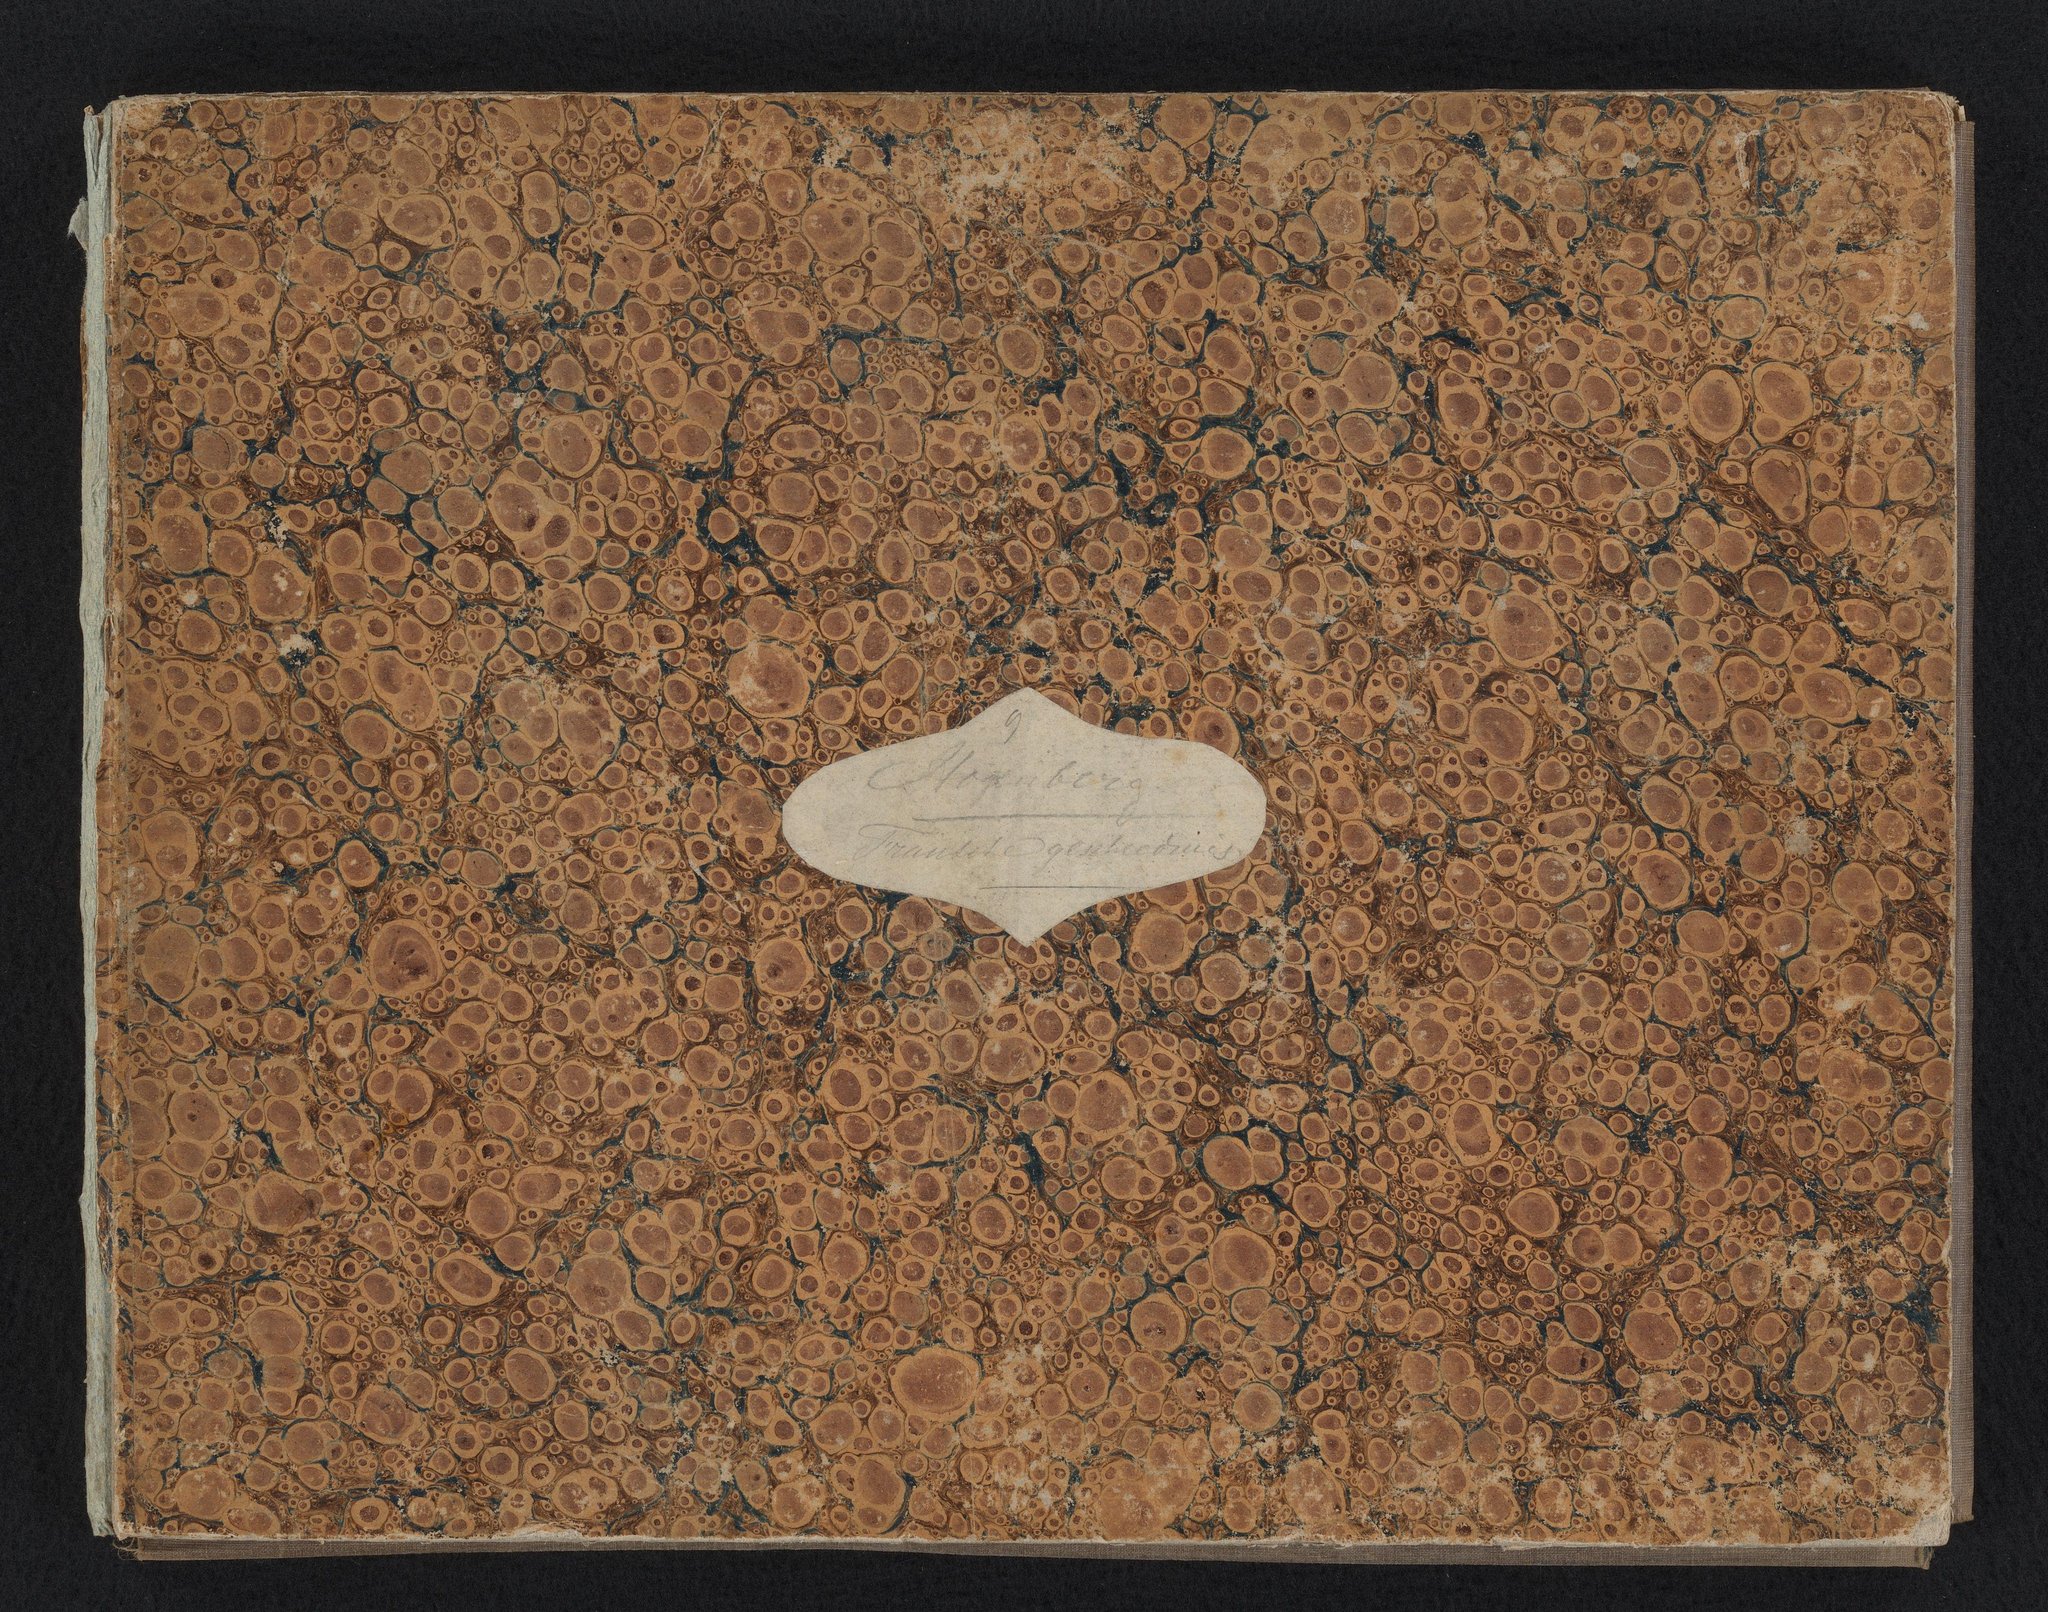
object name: prentrecueil, prentenalbum, prentalbum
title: Album met voorstellingen uit de geschiedenis van Frankrijk en Nederland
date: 1569-1583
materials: paper, wax, textile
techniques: decorated paper, etching, writing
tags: history, netherlands, france, belgium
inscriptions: signature: ‘J.T Bodel Nijenhuis’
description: Album met 57 etsen op 57 albumbladen. Het album bevat een complete reeks met 34 voorstellingen uit de Franse geschiedenis tussen 1559 en 1573 en 23 losse prenten uit een serie gebeurtenissen in Nederland tussen 1571 en 1576. De prenten uit de eerste gebonden serie zijn gemaakt door Frans Hogenberg naar ontwerp door Jean Perrissin en Jacques Tortorel (en mogelijk uitgesneden door Jacques le Challeux) voor de originele Franse uitgave getiteld: Premier Volume, contenant 40 Tableaux ou Histoires diverses qui soit memorables touchant les Guerres, Massacres (...). De eerste Duitse vertaling 'Der erste tail. Mancher layen gedencwirdiger historie vom kierg, mord und aüfrürern' is uitgegeven door Jean de Laon voor Nicolas Castellin en Pierre le Vignon in Genève in 1570. De titel op de titelpagina van deze editie luidt: Kurtzer begriff / dessjenigen was sich in Franckreich seither den frieden zwischen dem König Philippo auss Hispania unnd Henrich der zweite des Namens (...). Deze versie is mogelijk uitgegeven door Frans Hogenberg in Keulen in 1573. De tweede serie met losse prenten in dit album is gebruikt in Michael Aitsingers uitgave 'De Leone Belgico, ejusque topographica atque historica Descriptione' uit 1583. Hogenberg maakte meerdere reeksen met voorstellingen over de geschiedenis van verschillende landen, de belegering van Tunis, Franse Godsdienstoorlogen en verschillende politieke gebeurtenissen in Nederland en Duitsland. De reeksen in dit album zijn in de literatuur opgenomen als 'Serie 3: Franse Godsdienstoorlogen' en 'Serie 6: Nederlandse Gebeurtenissen, 1571-1576'.